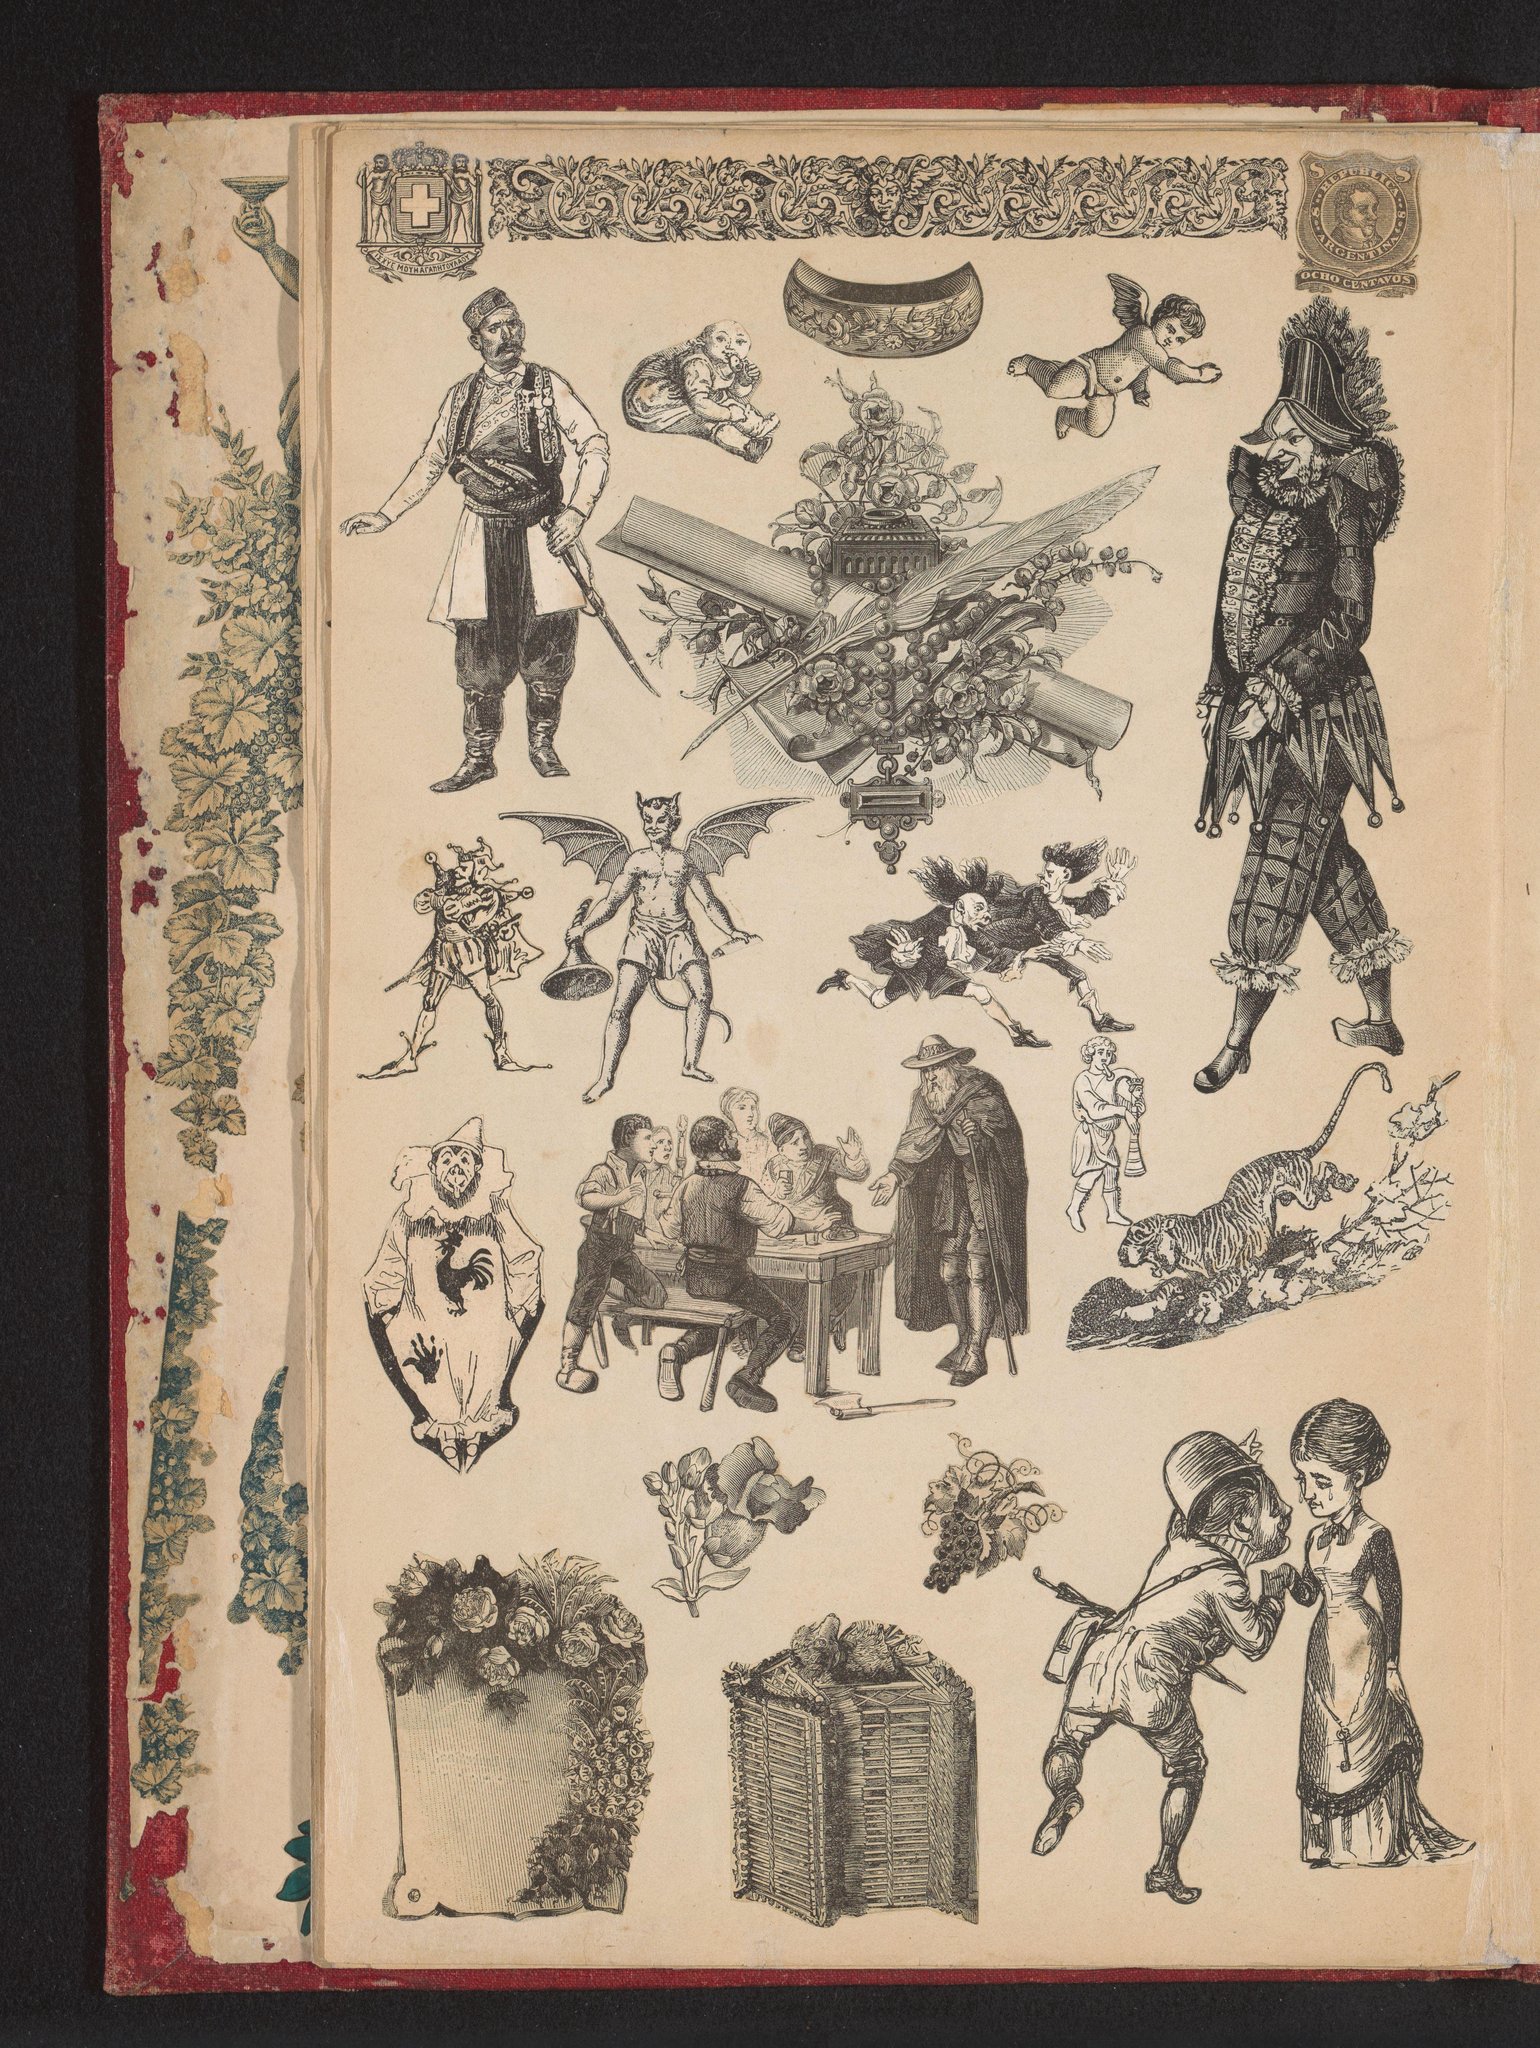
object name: collage visual work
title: Collage van uitgeknipte prenten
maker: Anonymous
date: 1870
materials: paper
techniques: engraving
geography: paris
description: Collage van uitgeknipte prenten. Onderdeel van een album met 18 bladen, aan beide zijden beplakt met uitgeknipte prenten, vermoedelijk afkomstig uit 19e-eeuwse tijdschiften.